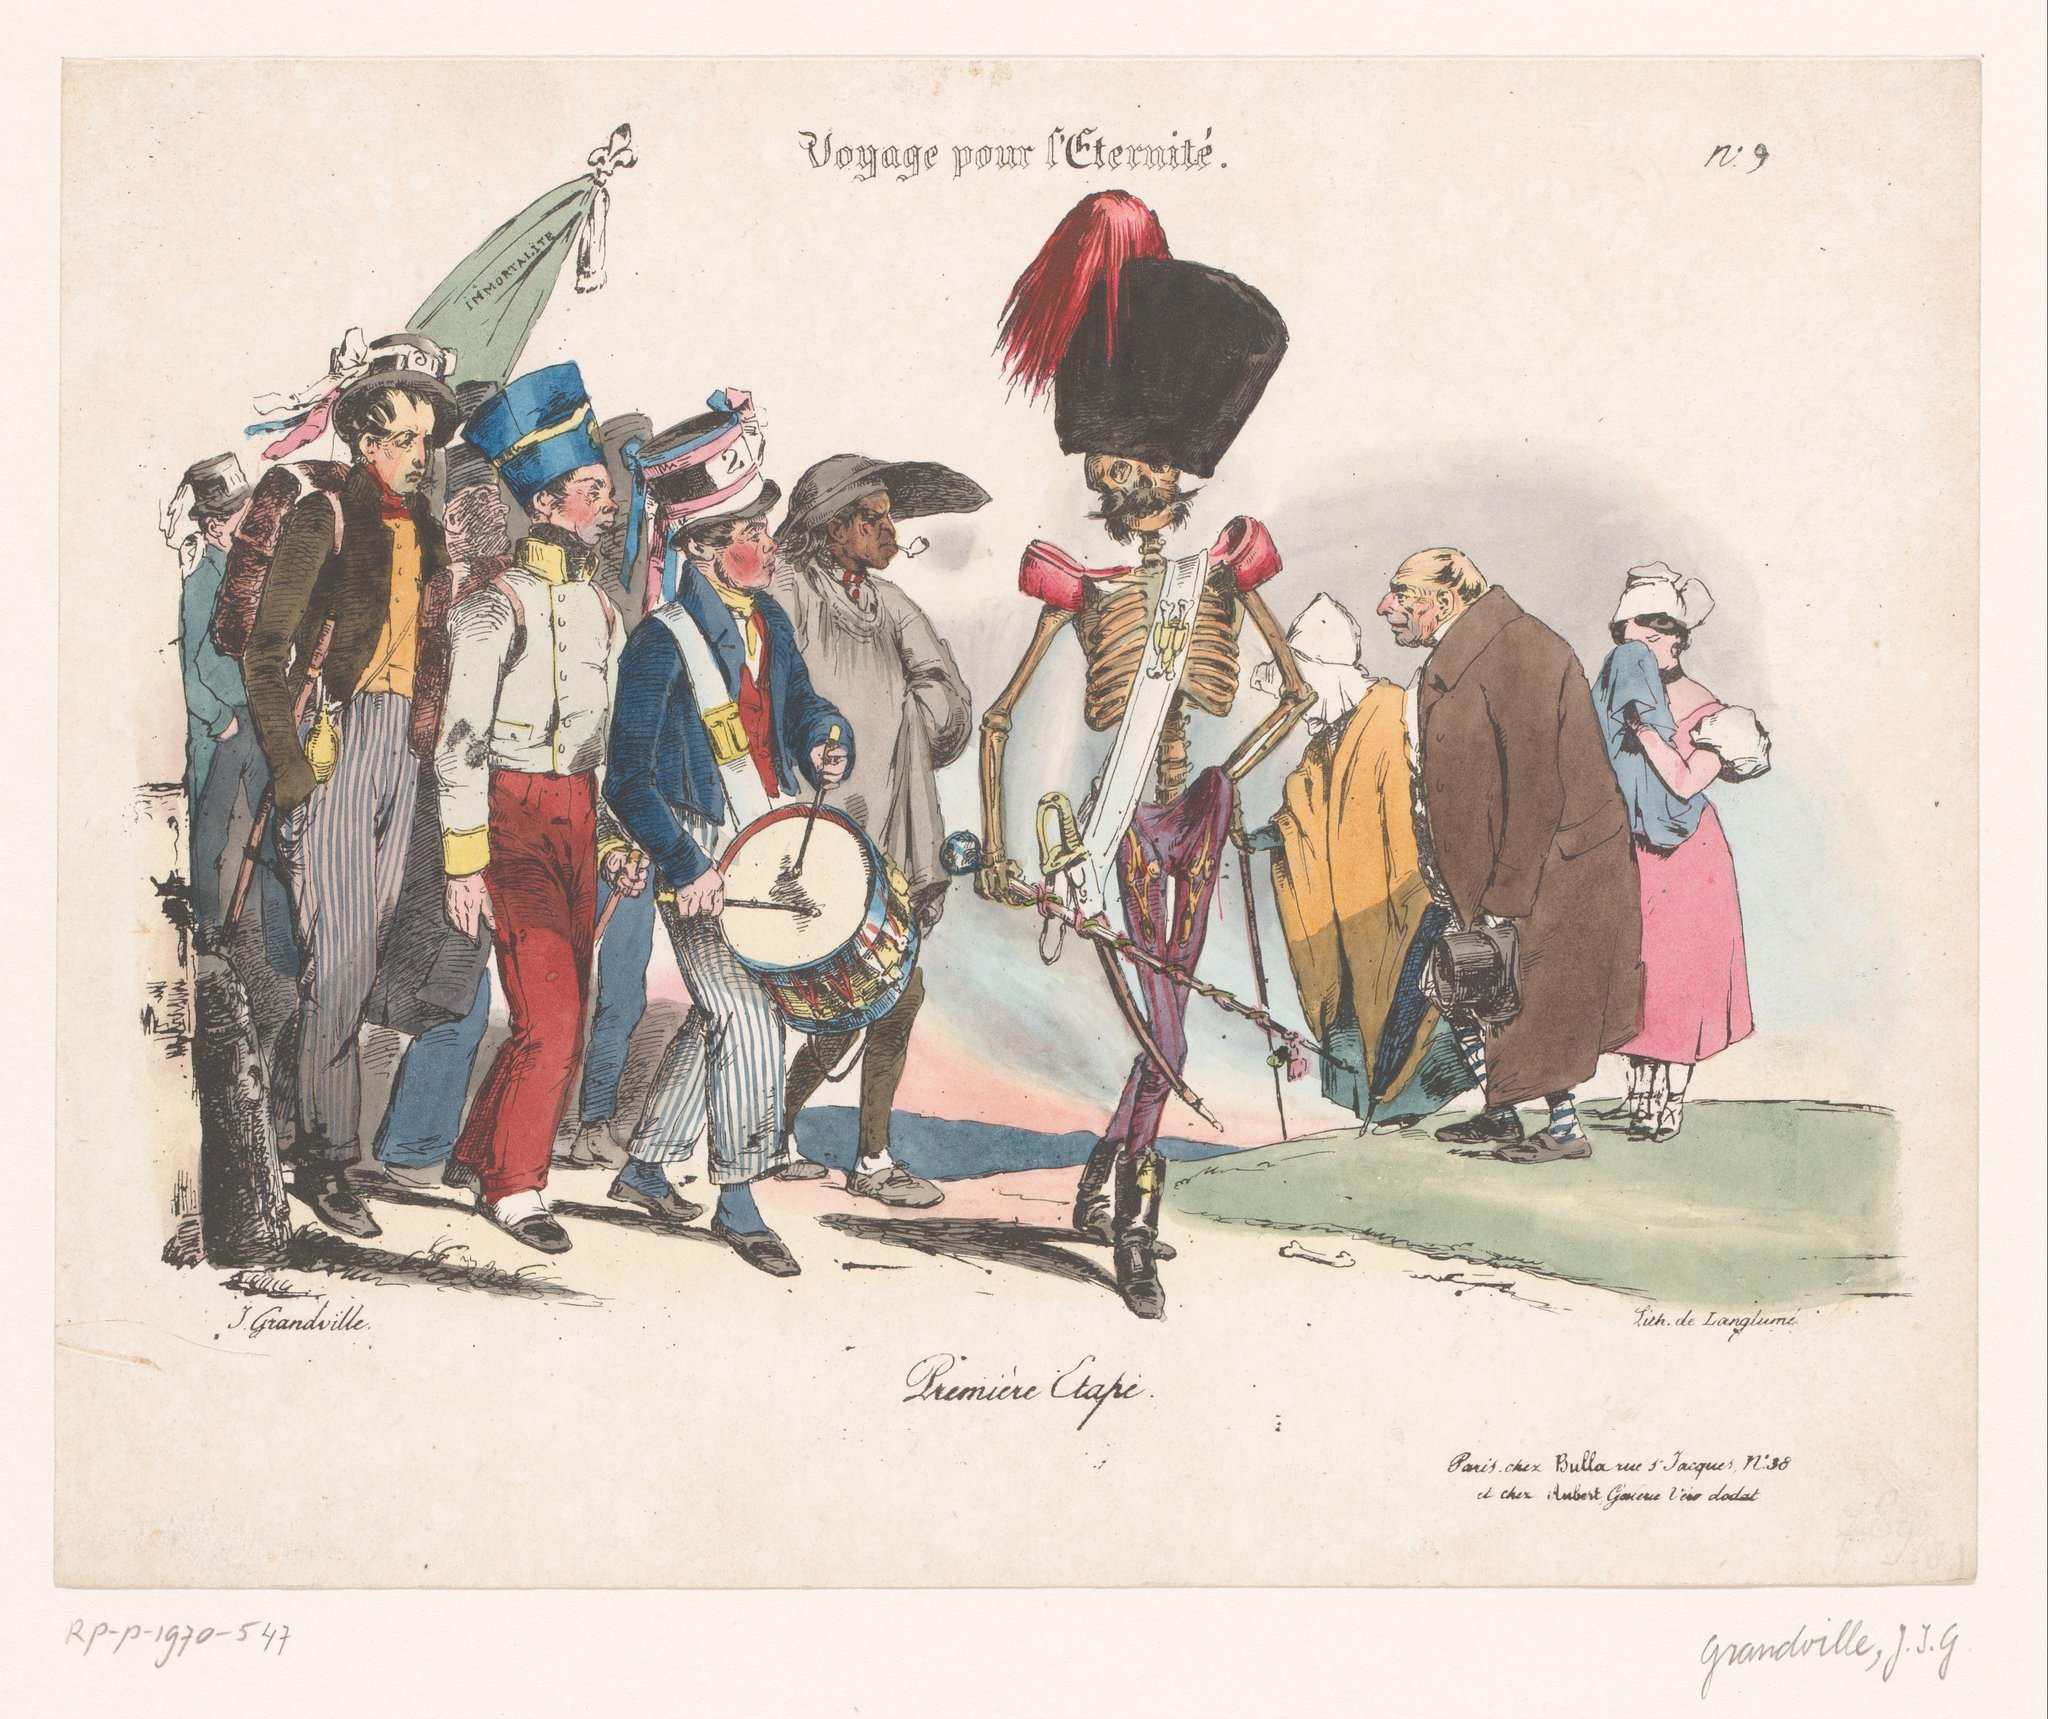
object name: print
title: Reis naar de eeuwigheid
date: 1830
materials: paper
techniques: hand coloring, lithograph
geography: paris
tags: marching away (troops), death as skeleton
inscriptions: collector's mark: Lugt 2228a